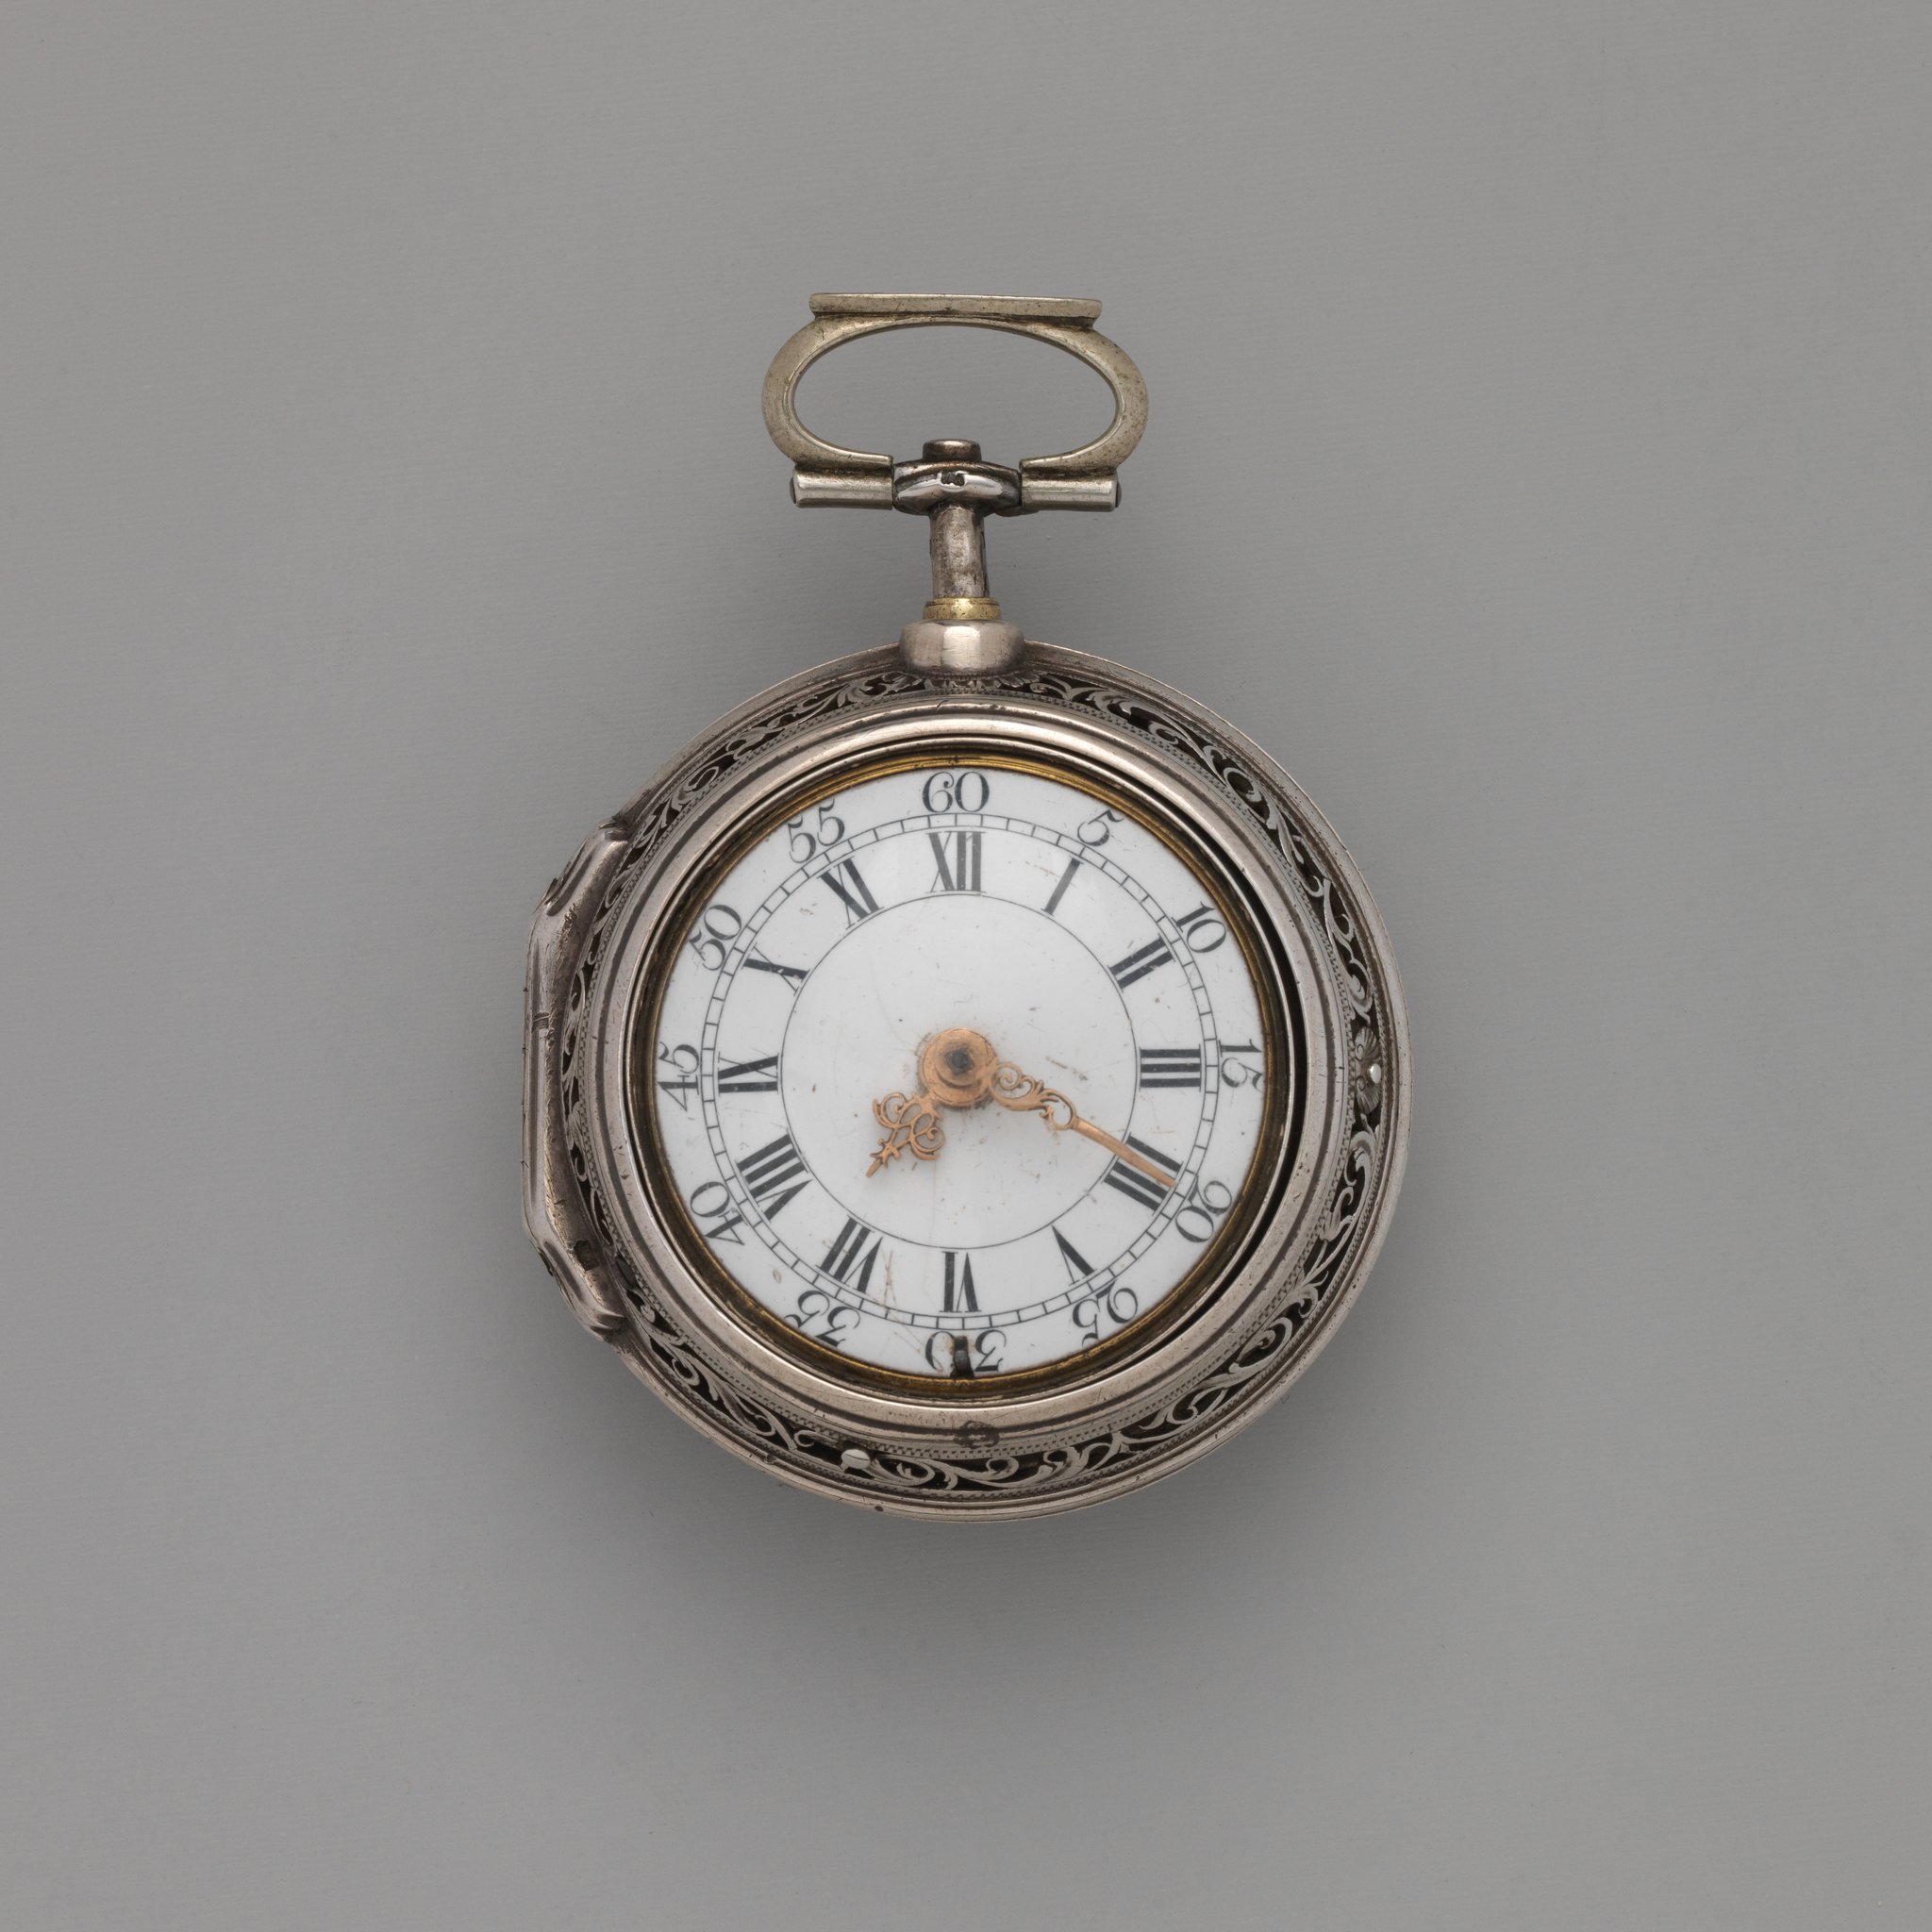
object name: watch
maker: thomas wagstaffe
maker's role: maker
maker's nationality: british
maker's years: 1724-1802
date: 1770-1790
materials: diamond, enamel, silver